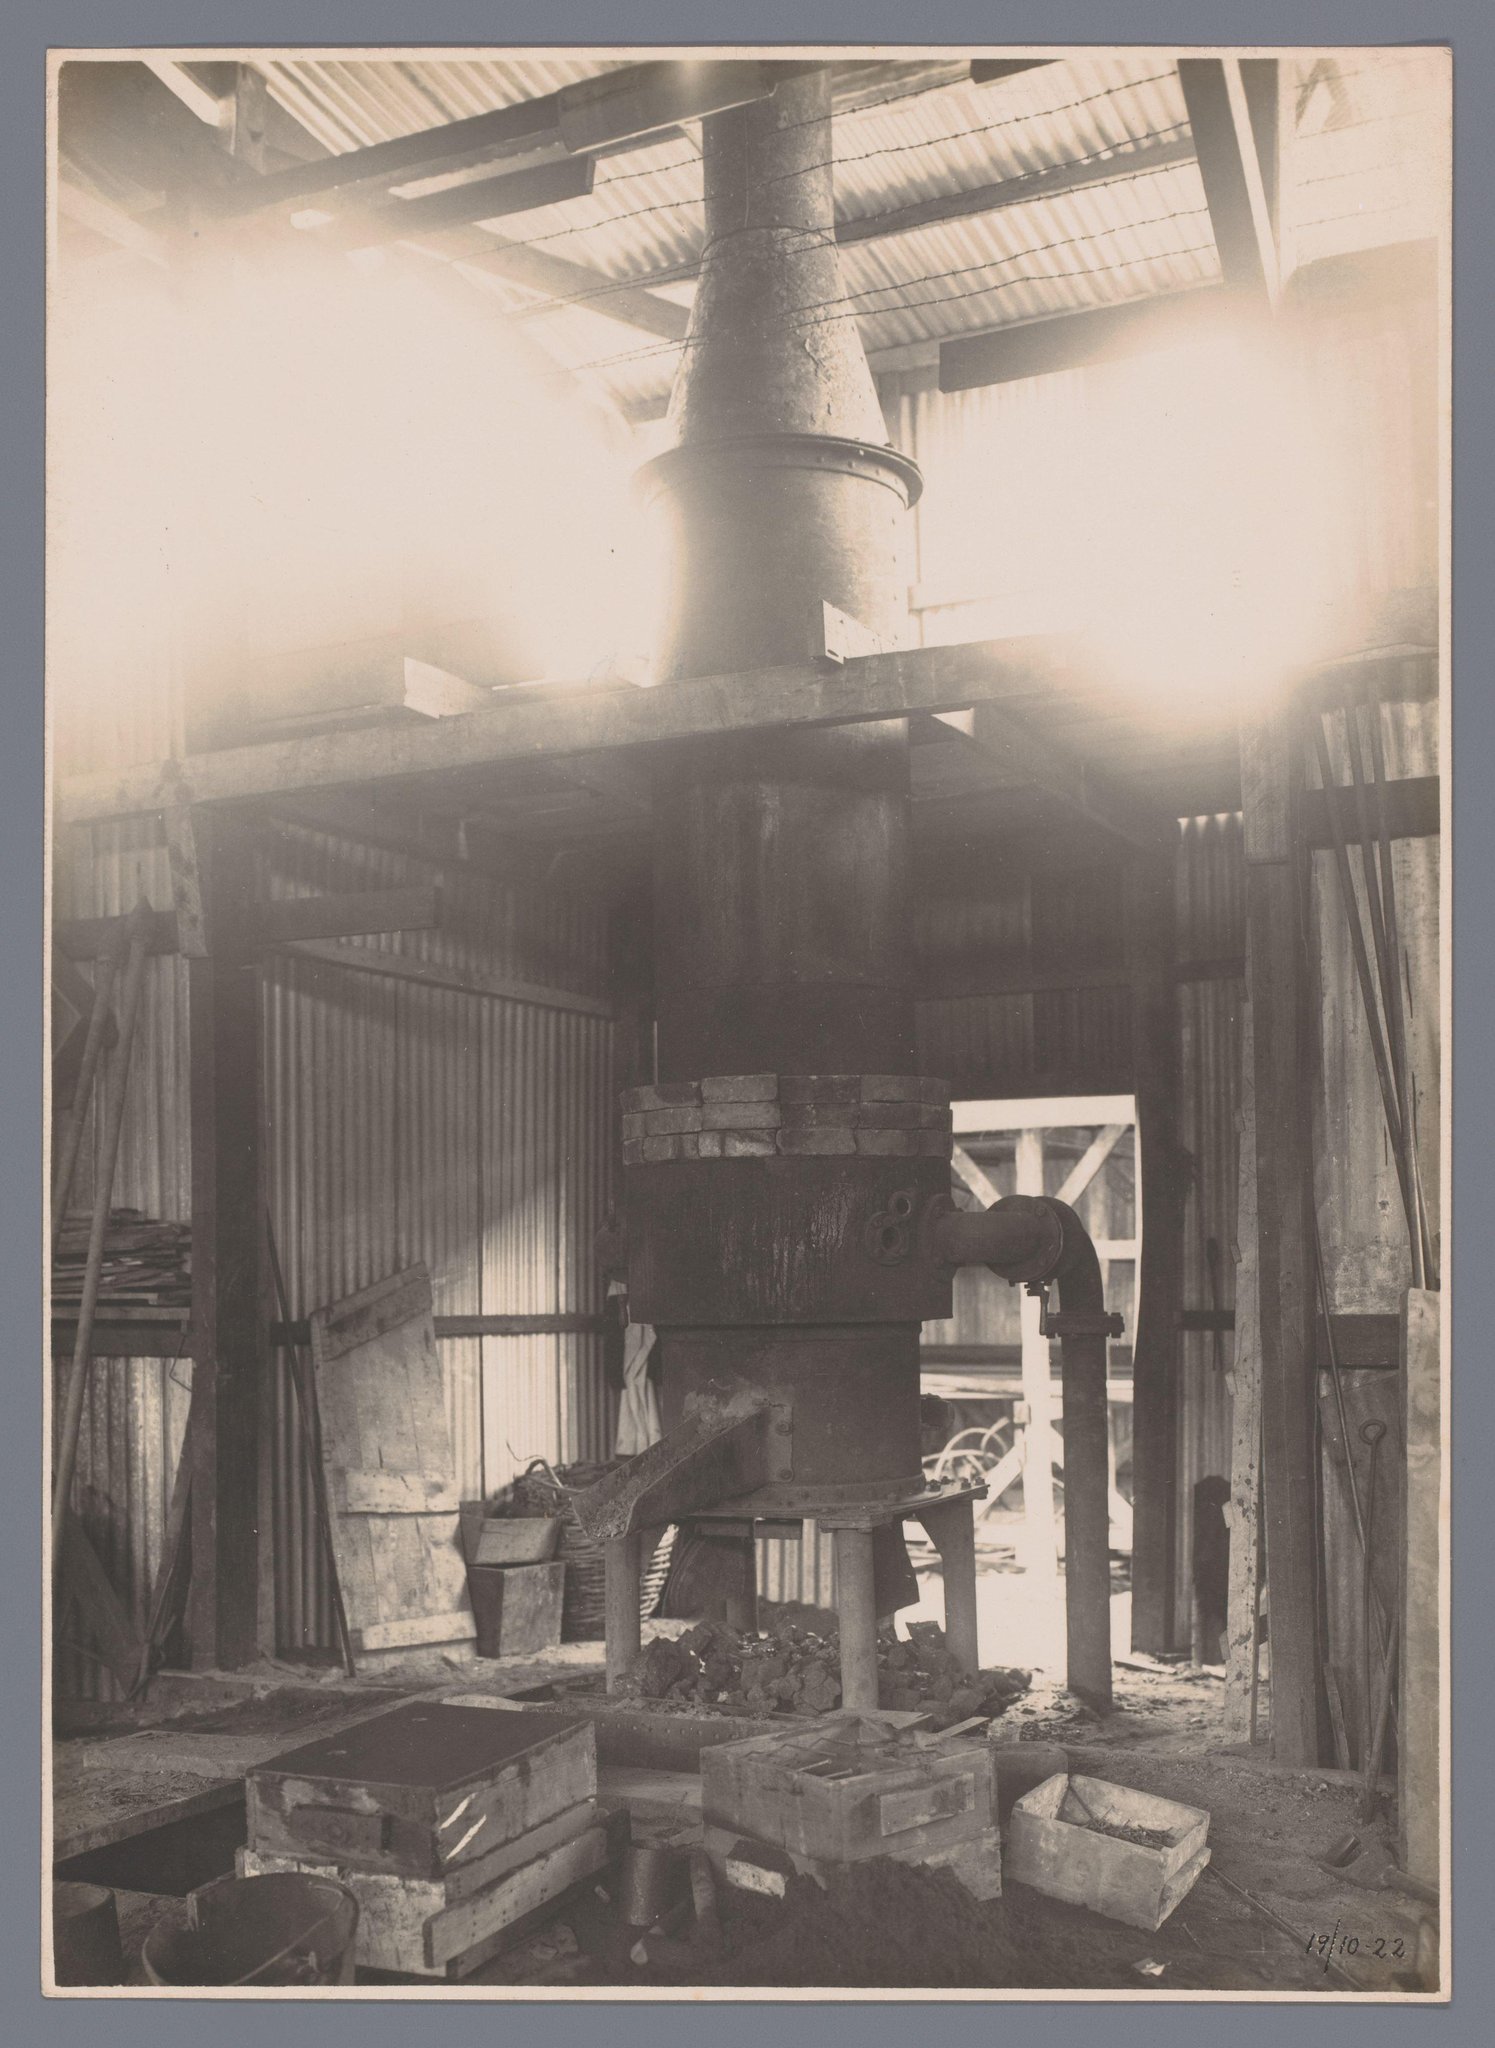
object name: photograph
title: Gietoven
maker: Anonymous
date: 1922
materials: photographic support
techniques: gelatin silver print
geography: belawan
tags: factory-interior, machine shop, blast-furnace, fire, oven, furnace ~ interior of industrial structure, building-site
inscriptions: date: ‘19/10-22’, annotation: ‘No. 260 Gietoven’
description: Werkplaats met gietoven. Genummerd: 260. Onderdeel van de groep van losse foto's over de aanleg van de haven Belawan aan de kust voor Medan, Sumatra 1921-1922.